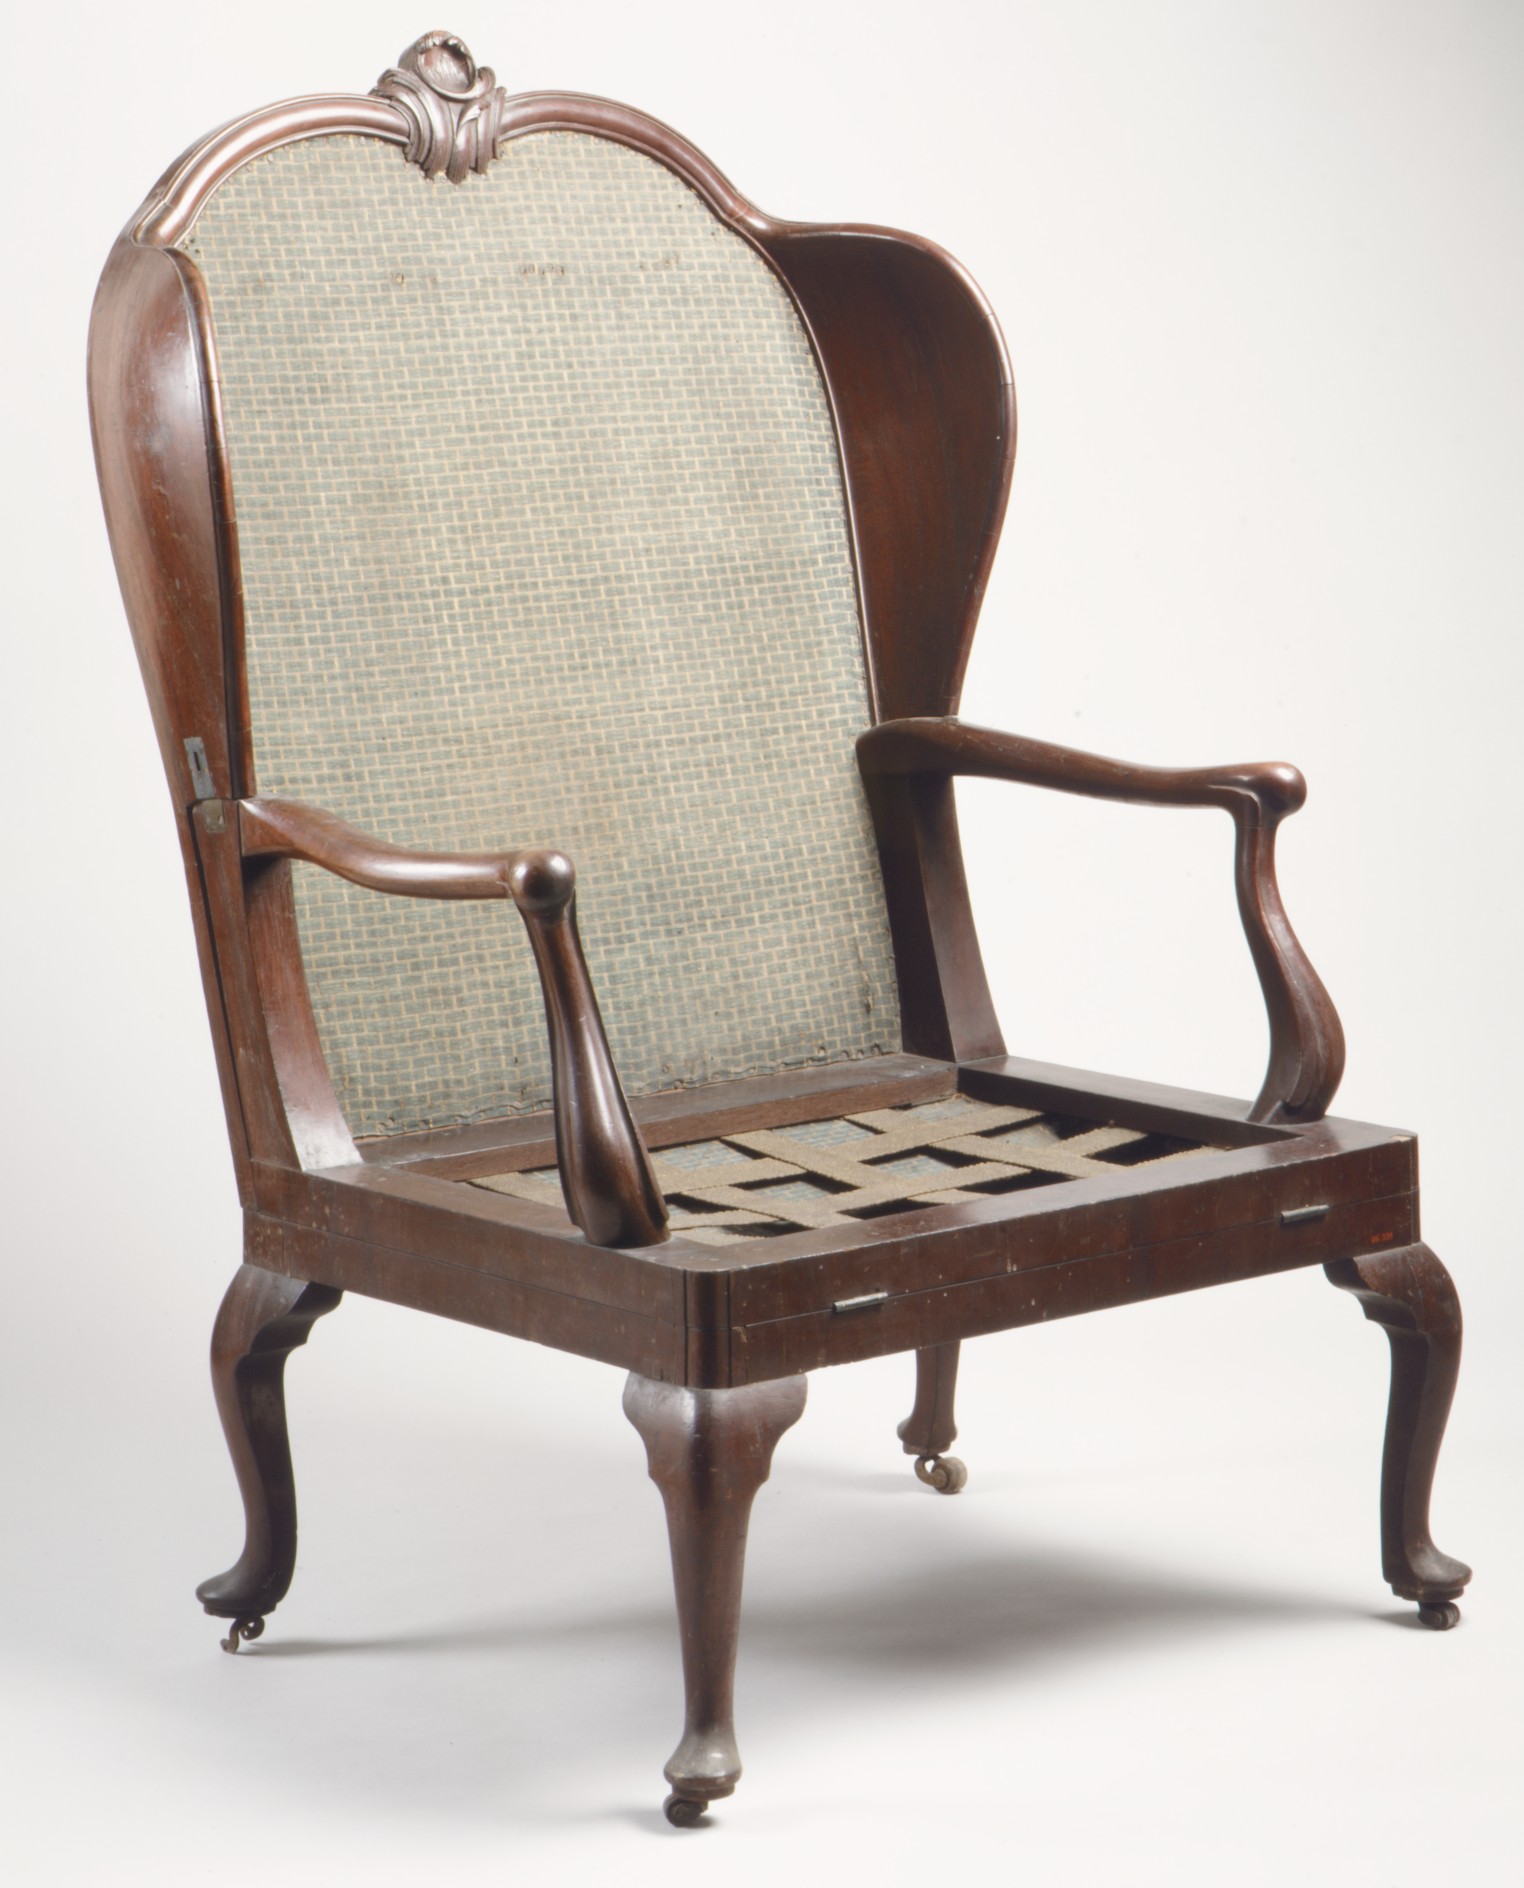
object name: folding bed chair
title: Folding bed chair (porter's chair)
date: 1760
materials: wood